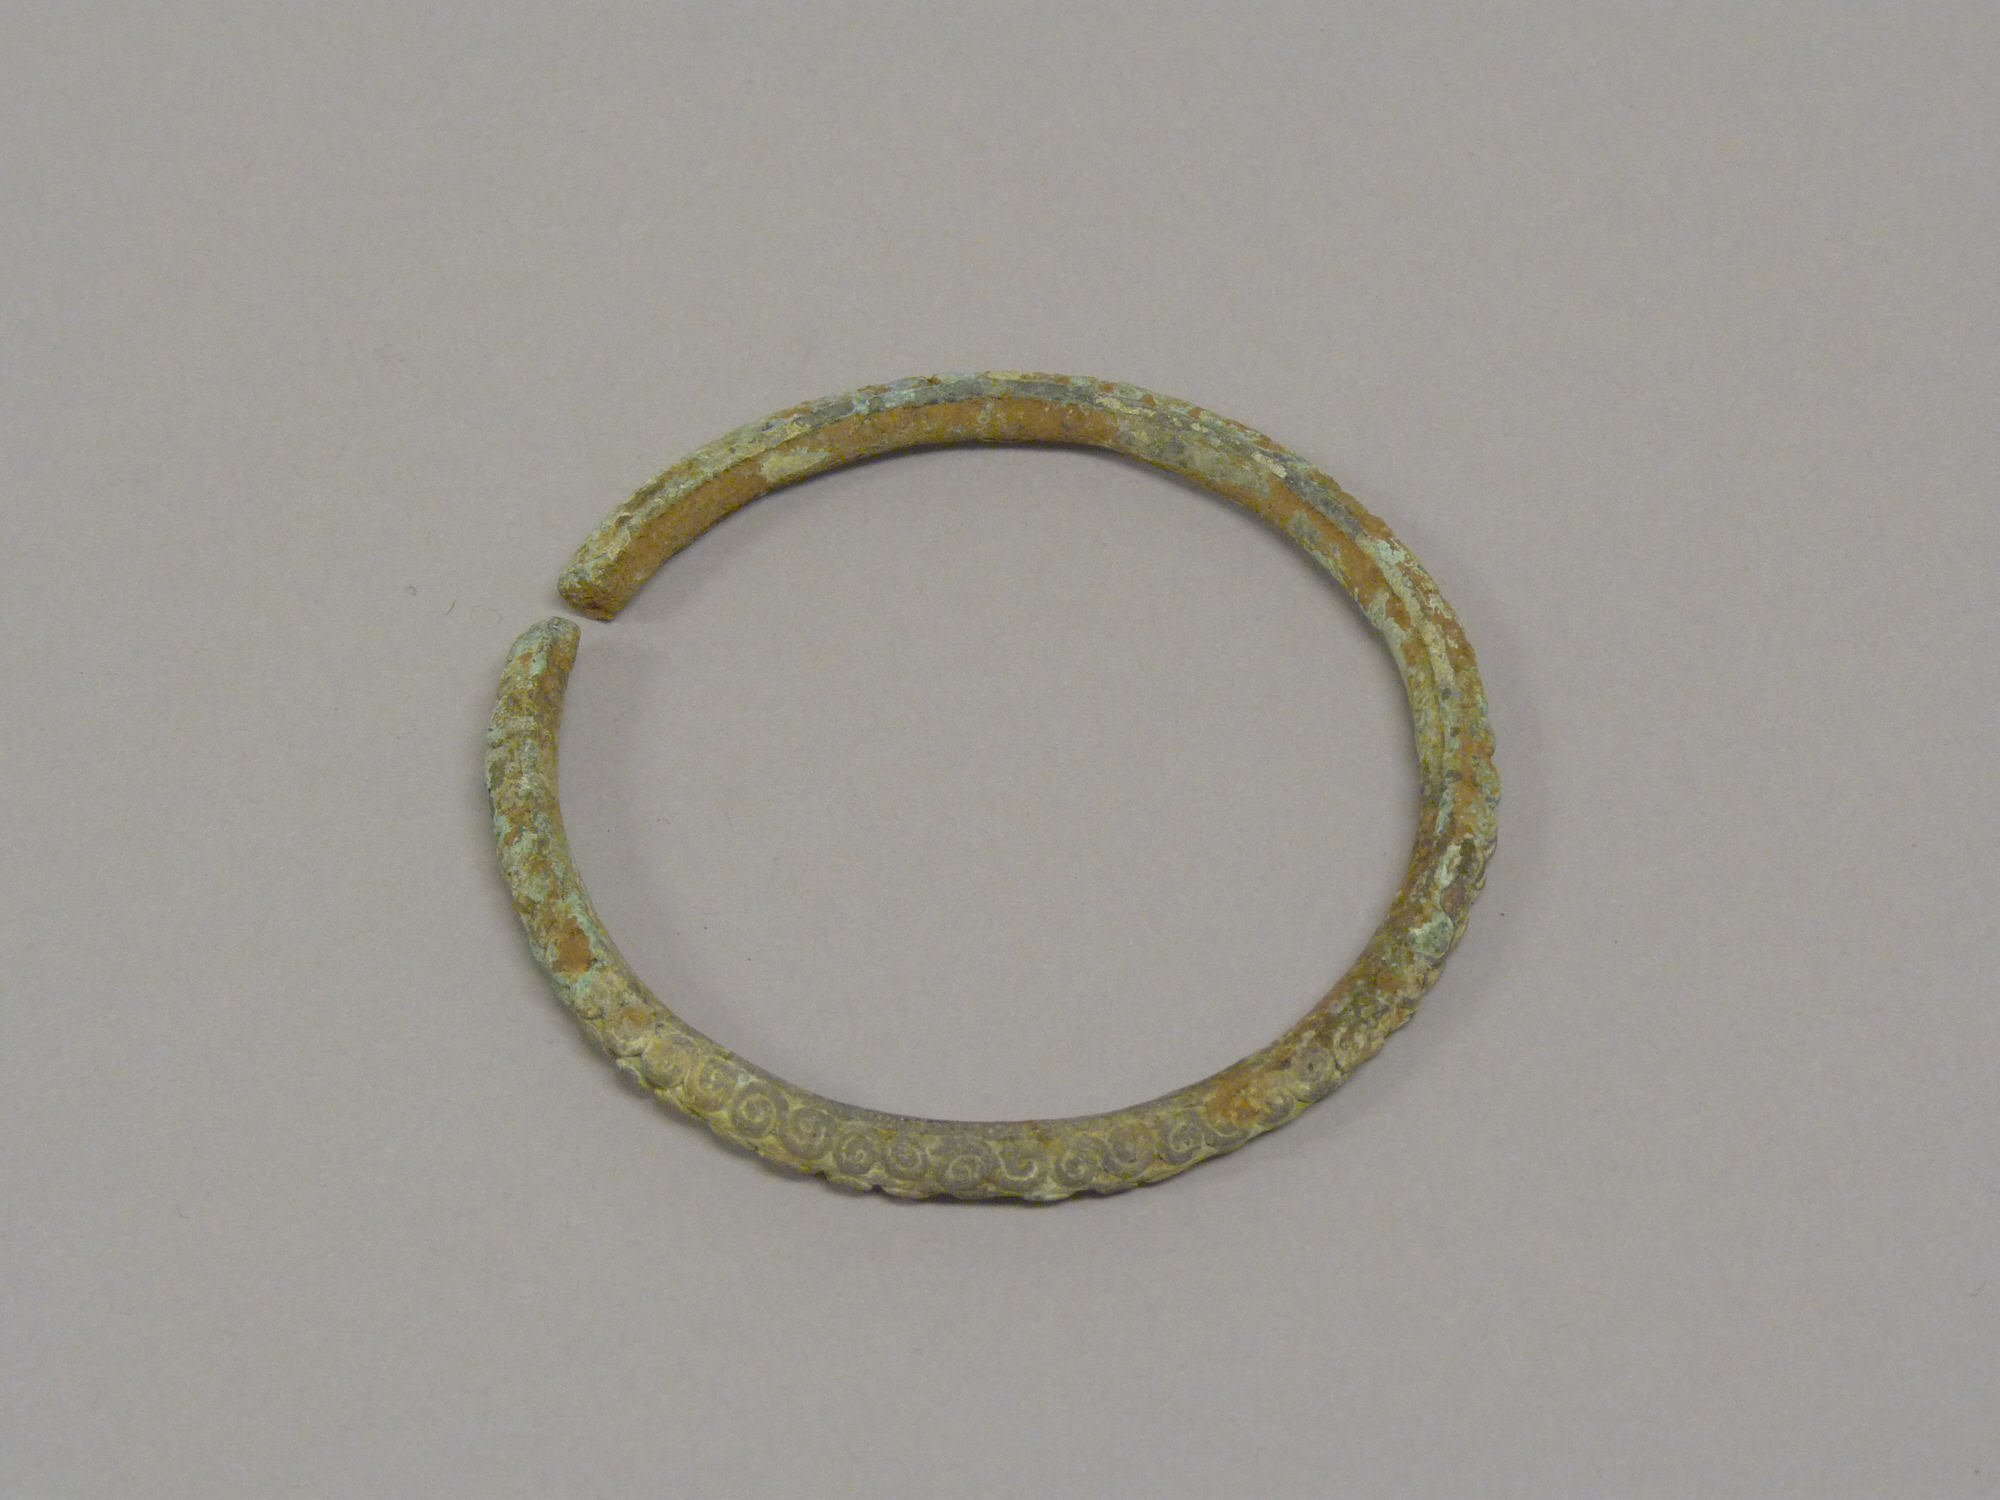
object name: bangle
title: Bangle with Circular Motifs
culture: thai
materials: bronze